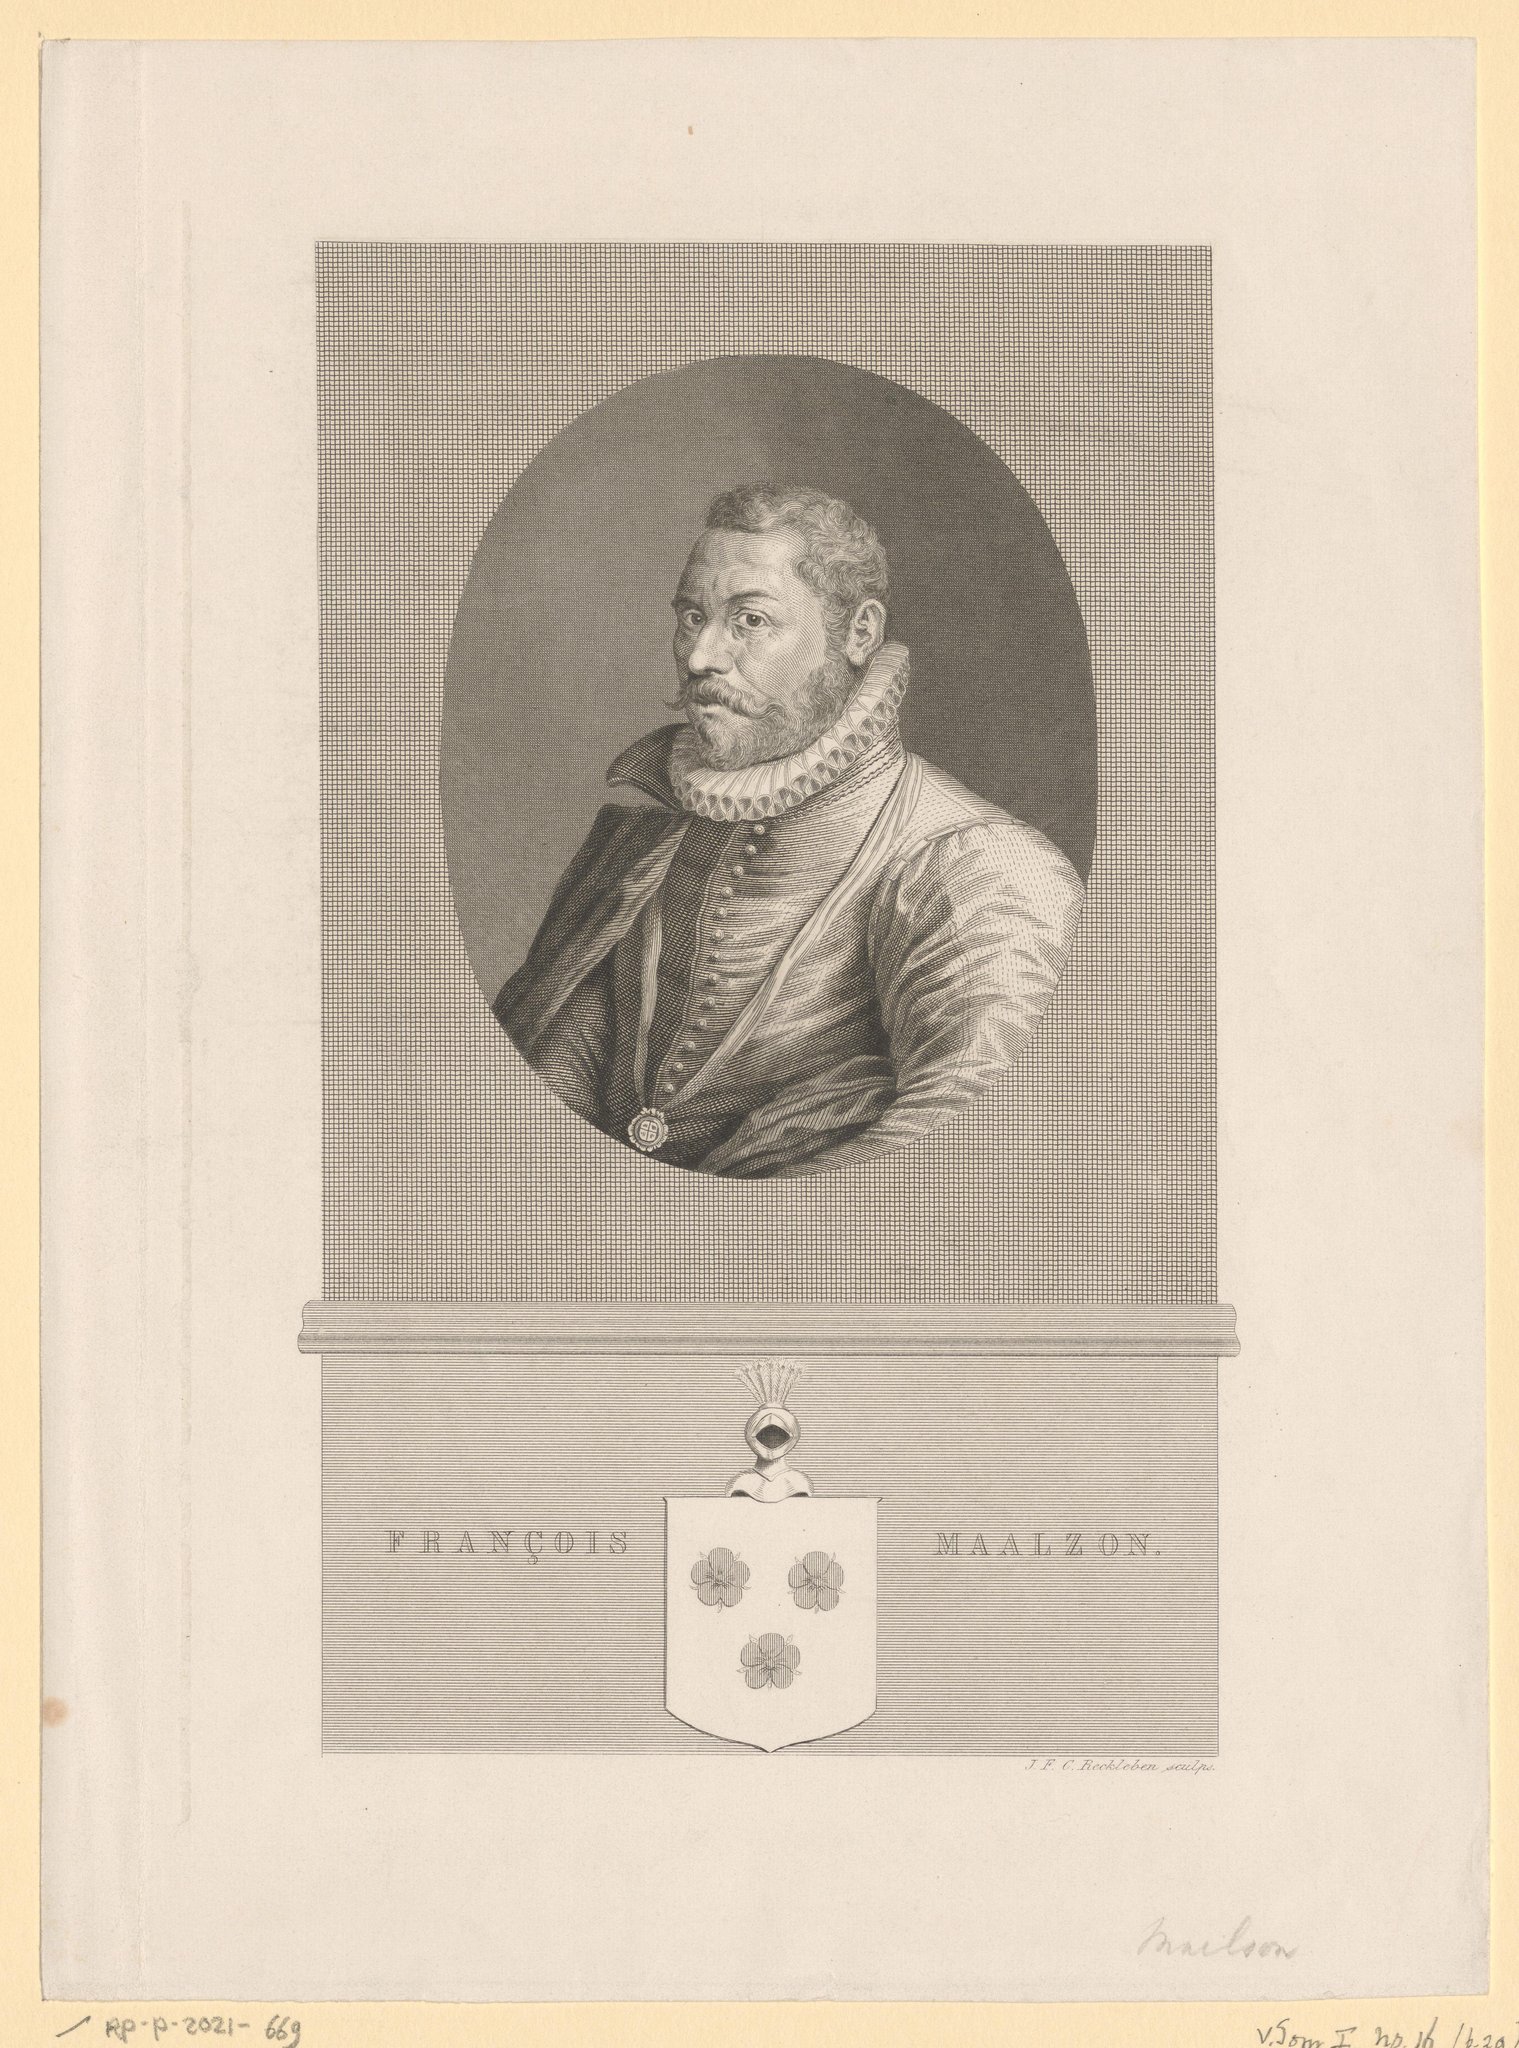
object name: book illustration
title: Portret van François Maelson op 54-jarige leeftijd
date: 1840-1884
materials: paper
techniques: engraving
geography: amsterdam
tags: enkhuizen, historical persons, politician, e.g. party leader, physician, doctor (+ portrait of scholar, scientist)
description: Prent uit: Arend, Johannes Pieter. Algemeene geschiedenis des vaderlands van de vroegste tijden tot op heden. 5 dln. Amsterdam: J.F. Schleijer, [1840-1884].